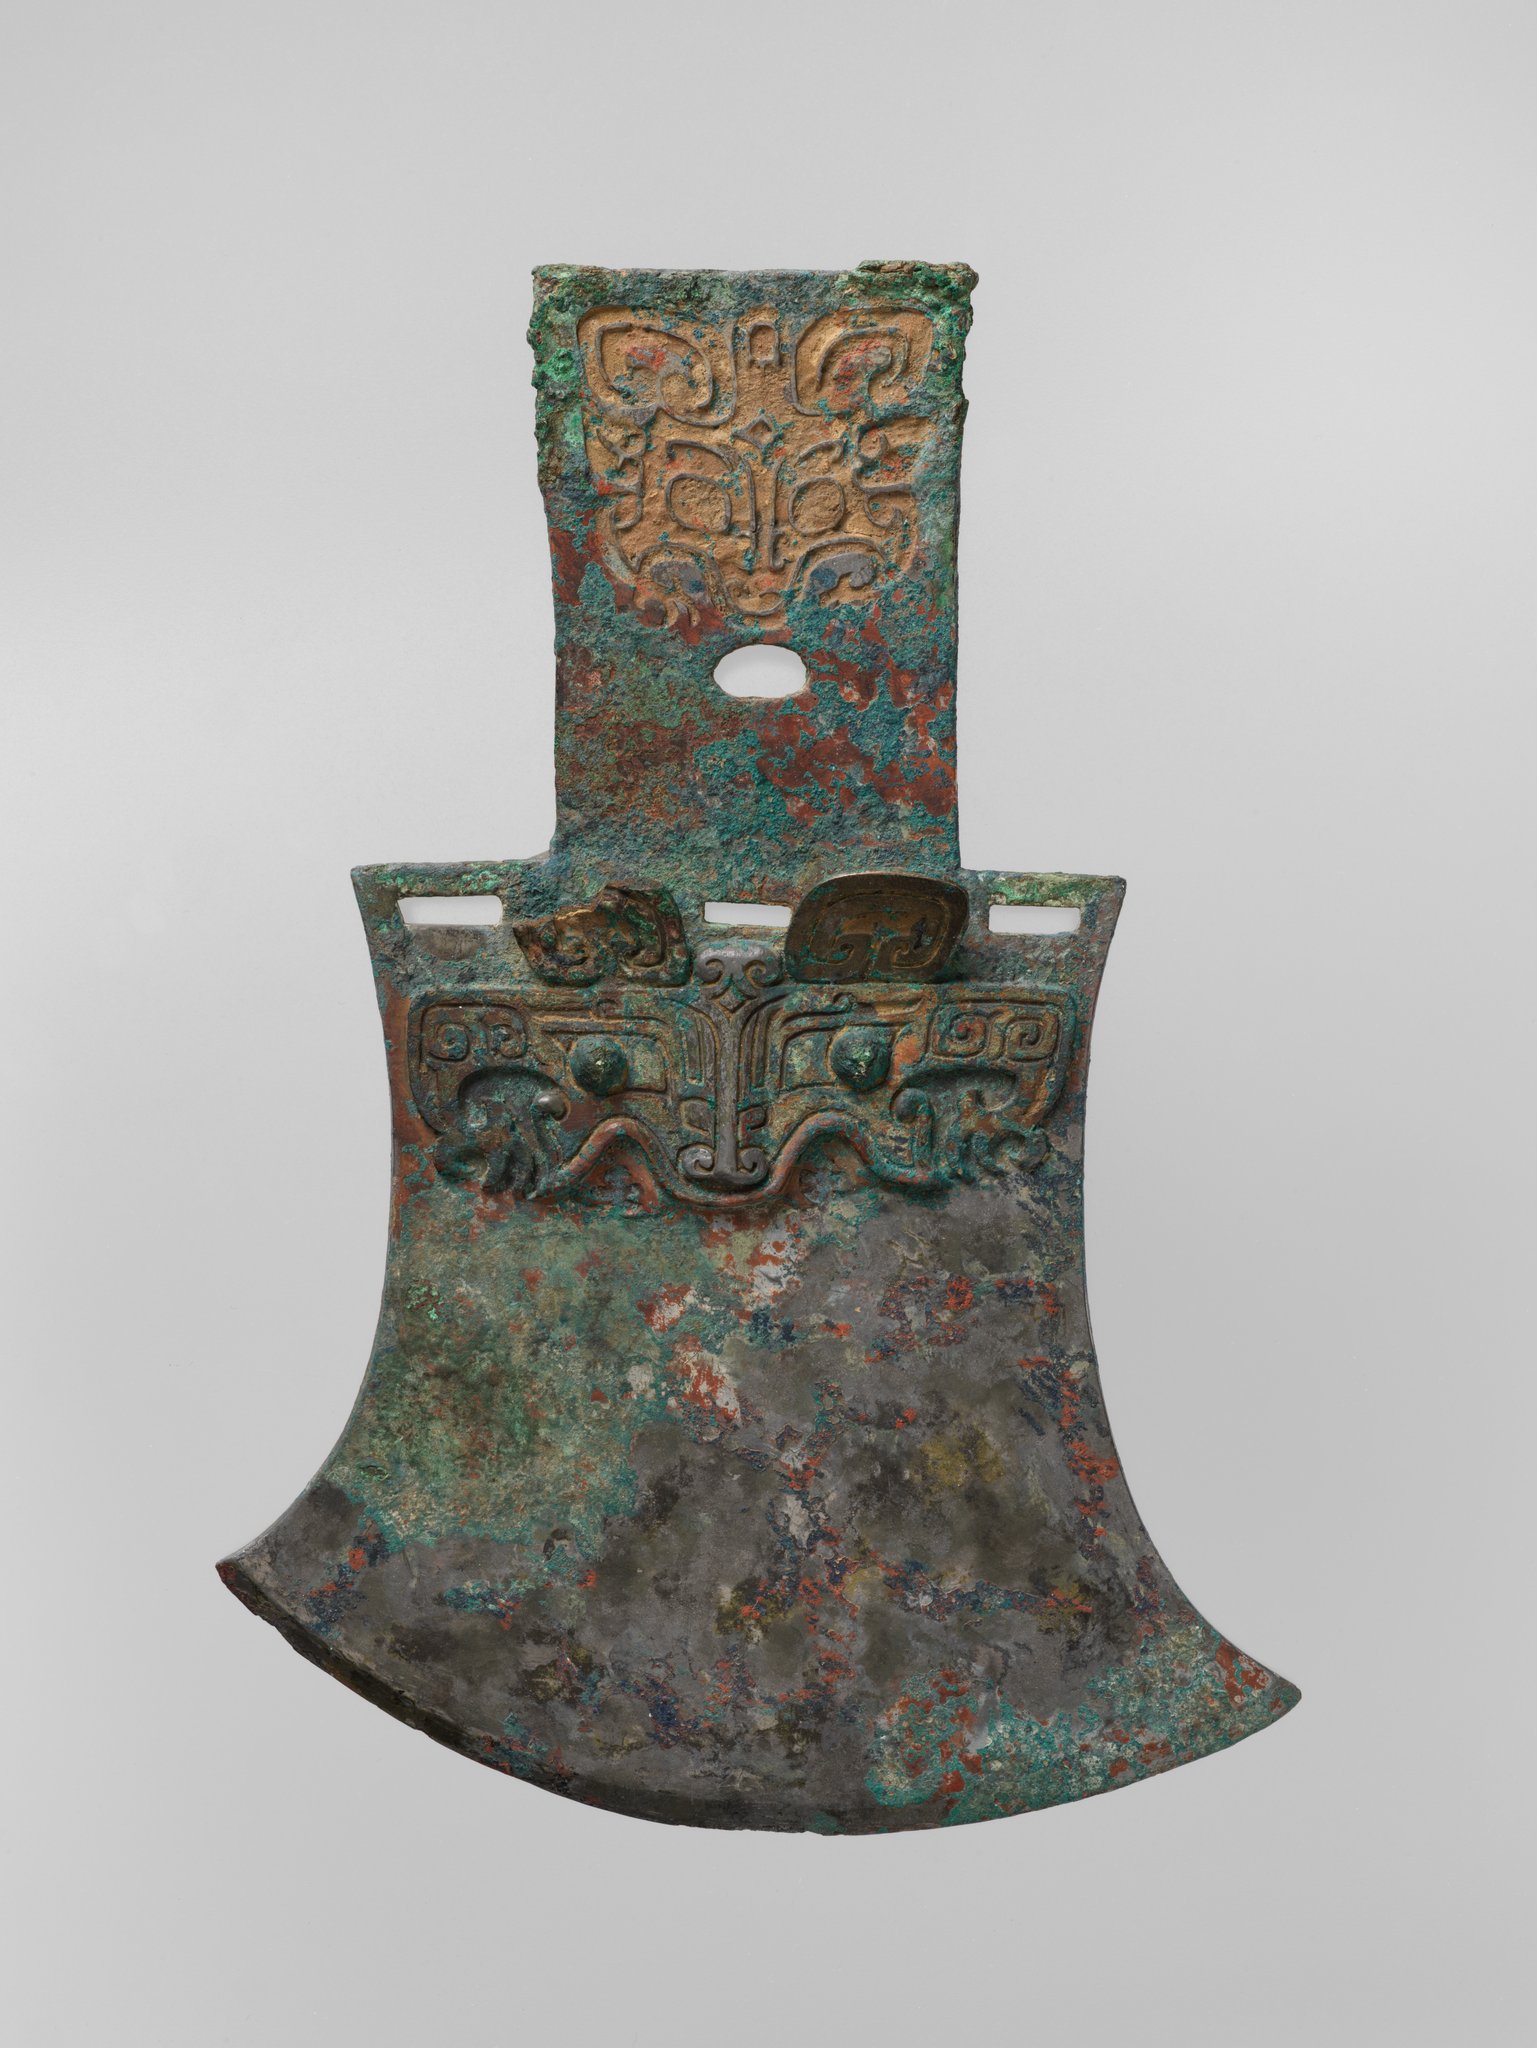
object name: axe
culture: chinese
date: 1200-1001 BCE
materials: bronze